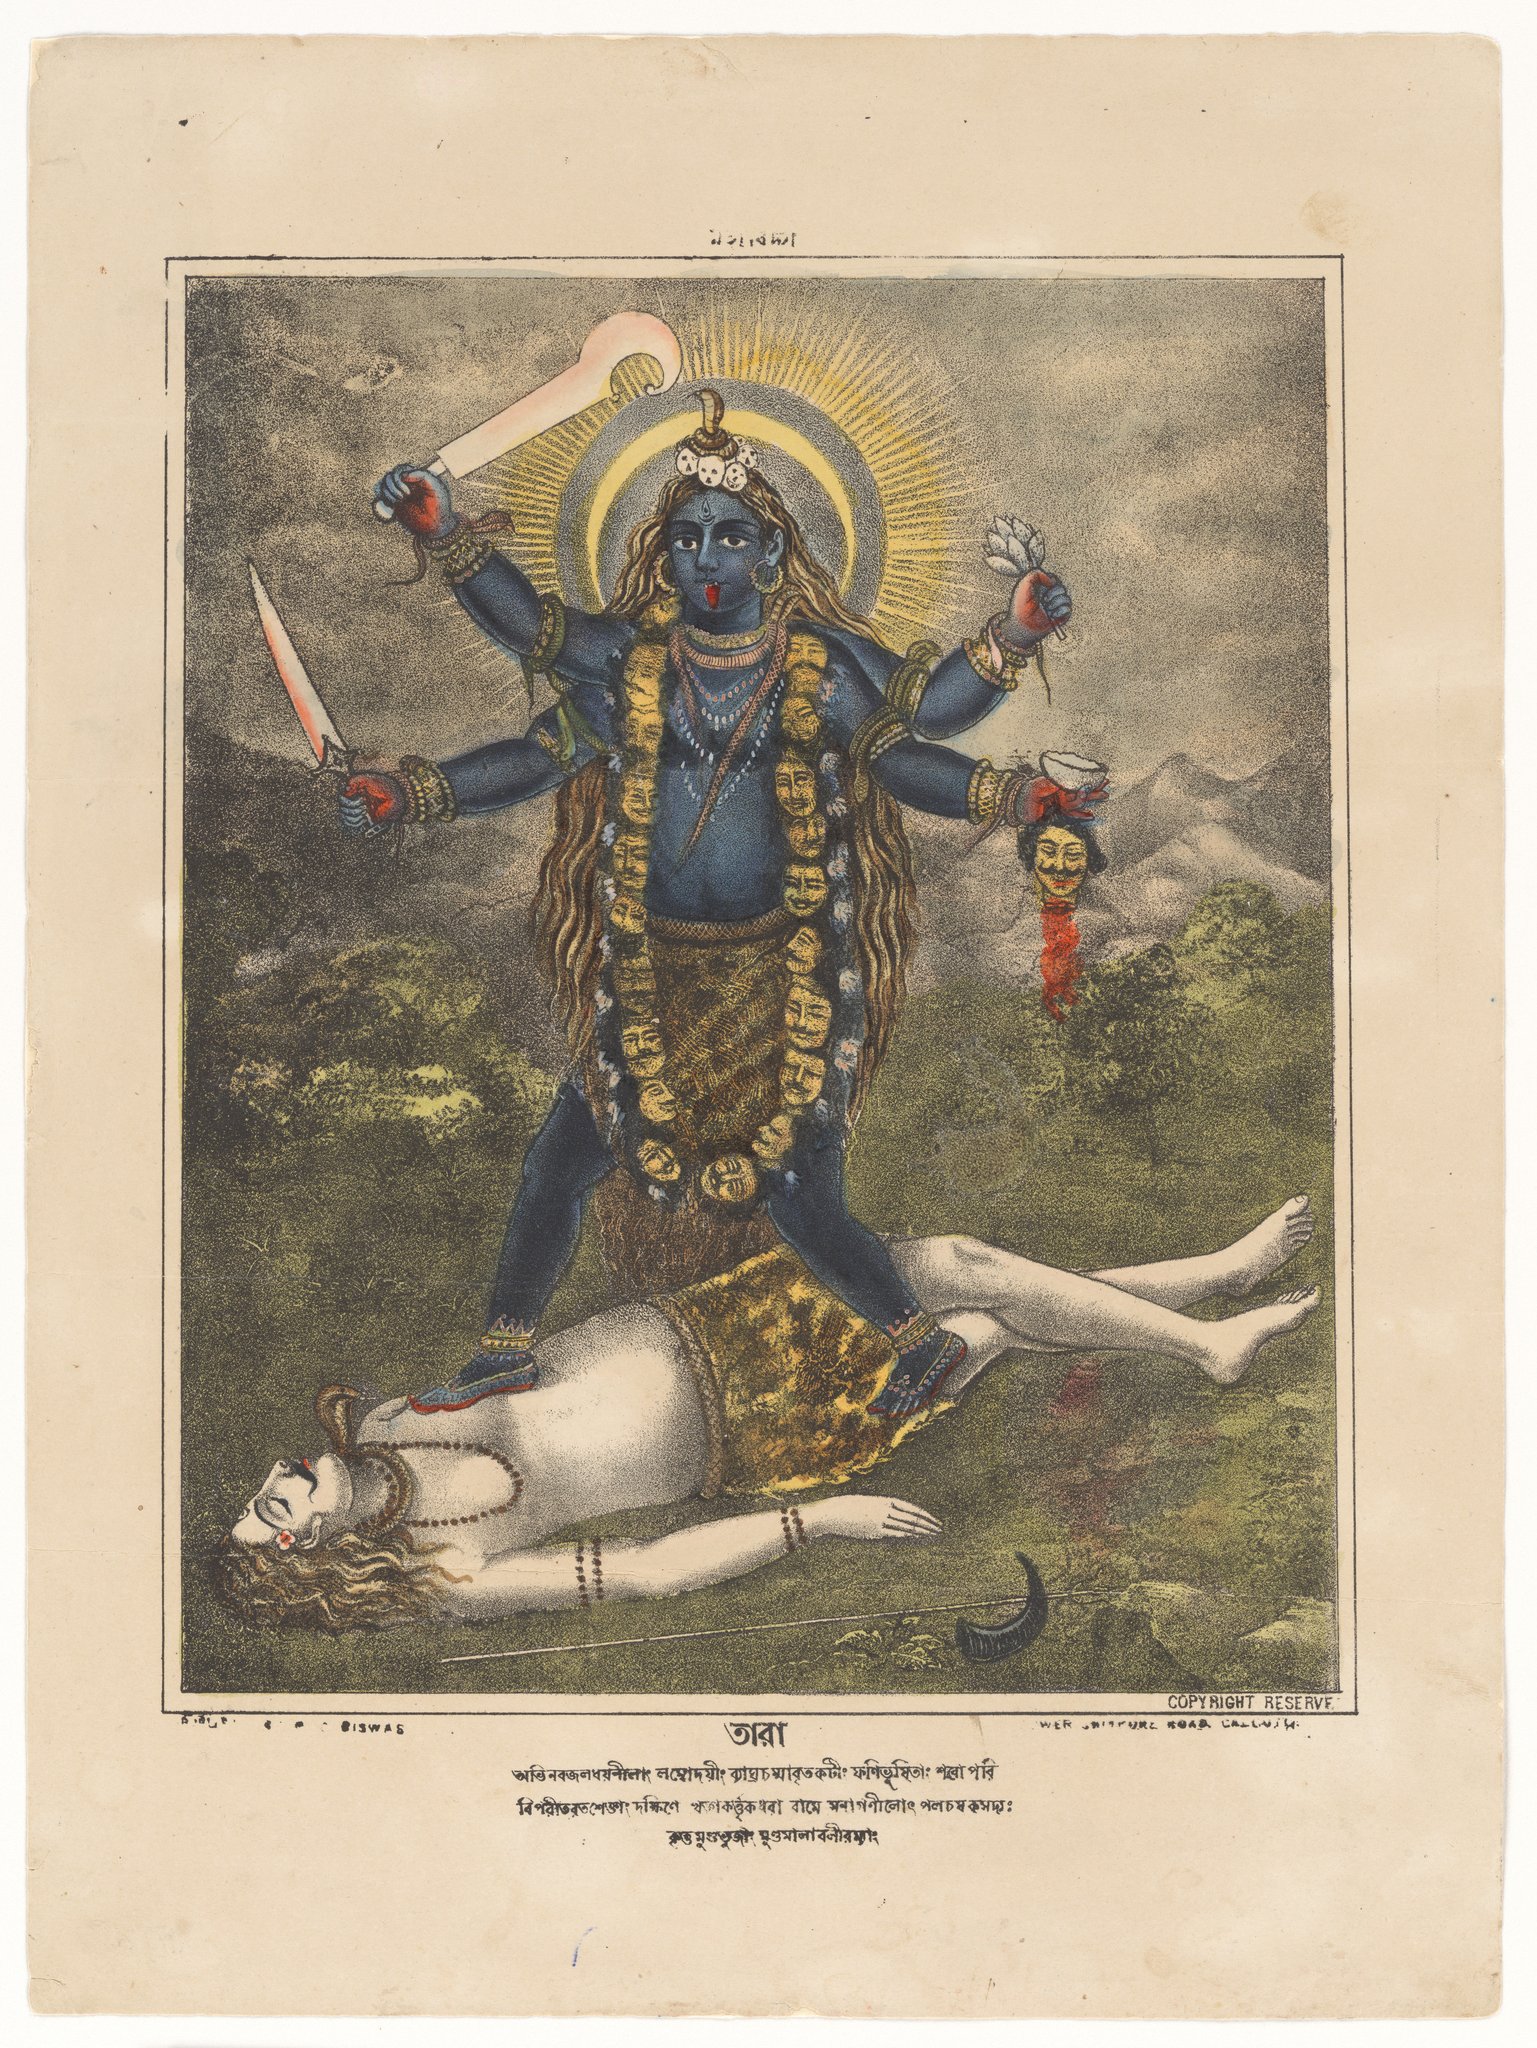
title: Goddess Tara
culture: west bengali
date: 1880-1885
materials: glaze, watercolor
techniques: hand coloring, lithograph, printing